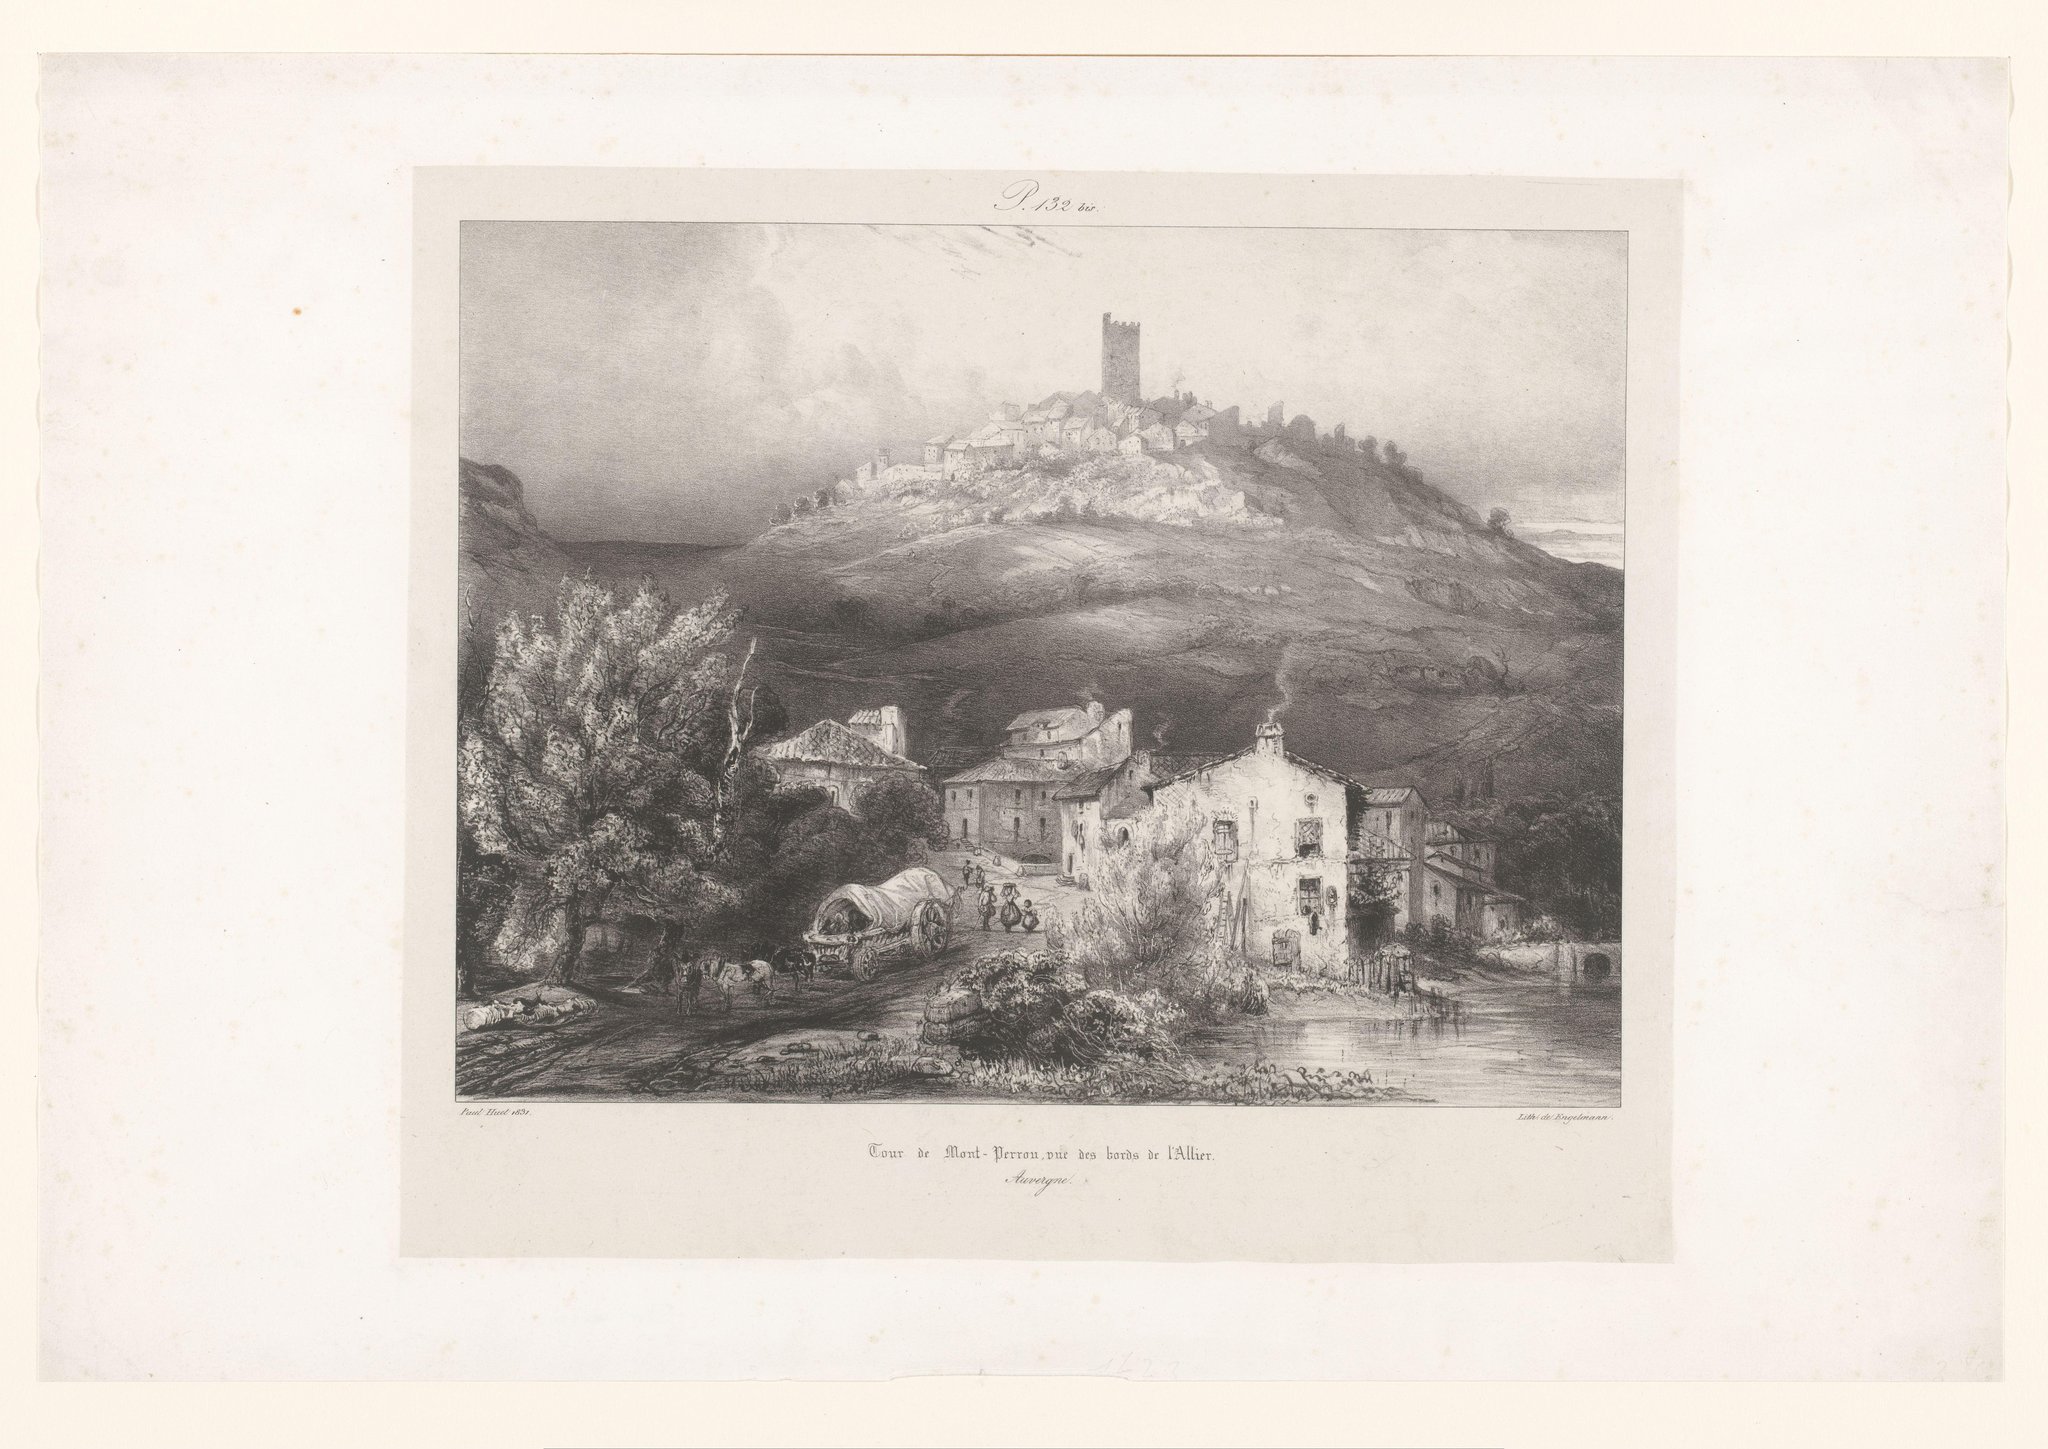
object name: print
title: Zicht op de toren van Mont-Perrou in de Auvergne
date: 1831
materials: paper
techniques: lithograph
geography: paris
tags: landscape with tower or castle (+ city(-scape) with figures, staffage)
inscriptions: collector's mark: Lugt 2760, collector's mark: Lugt 2228a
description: Prent gepubliceerd in: Nodier, Ch., Taylor, J. en Cailleux, A. de. Voyages pittoresques et romantiques dans l'ancienne France. Parijs: P. Didot l'ainé, 1831. pl. 132 bis.